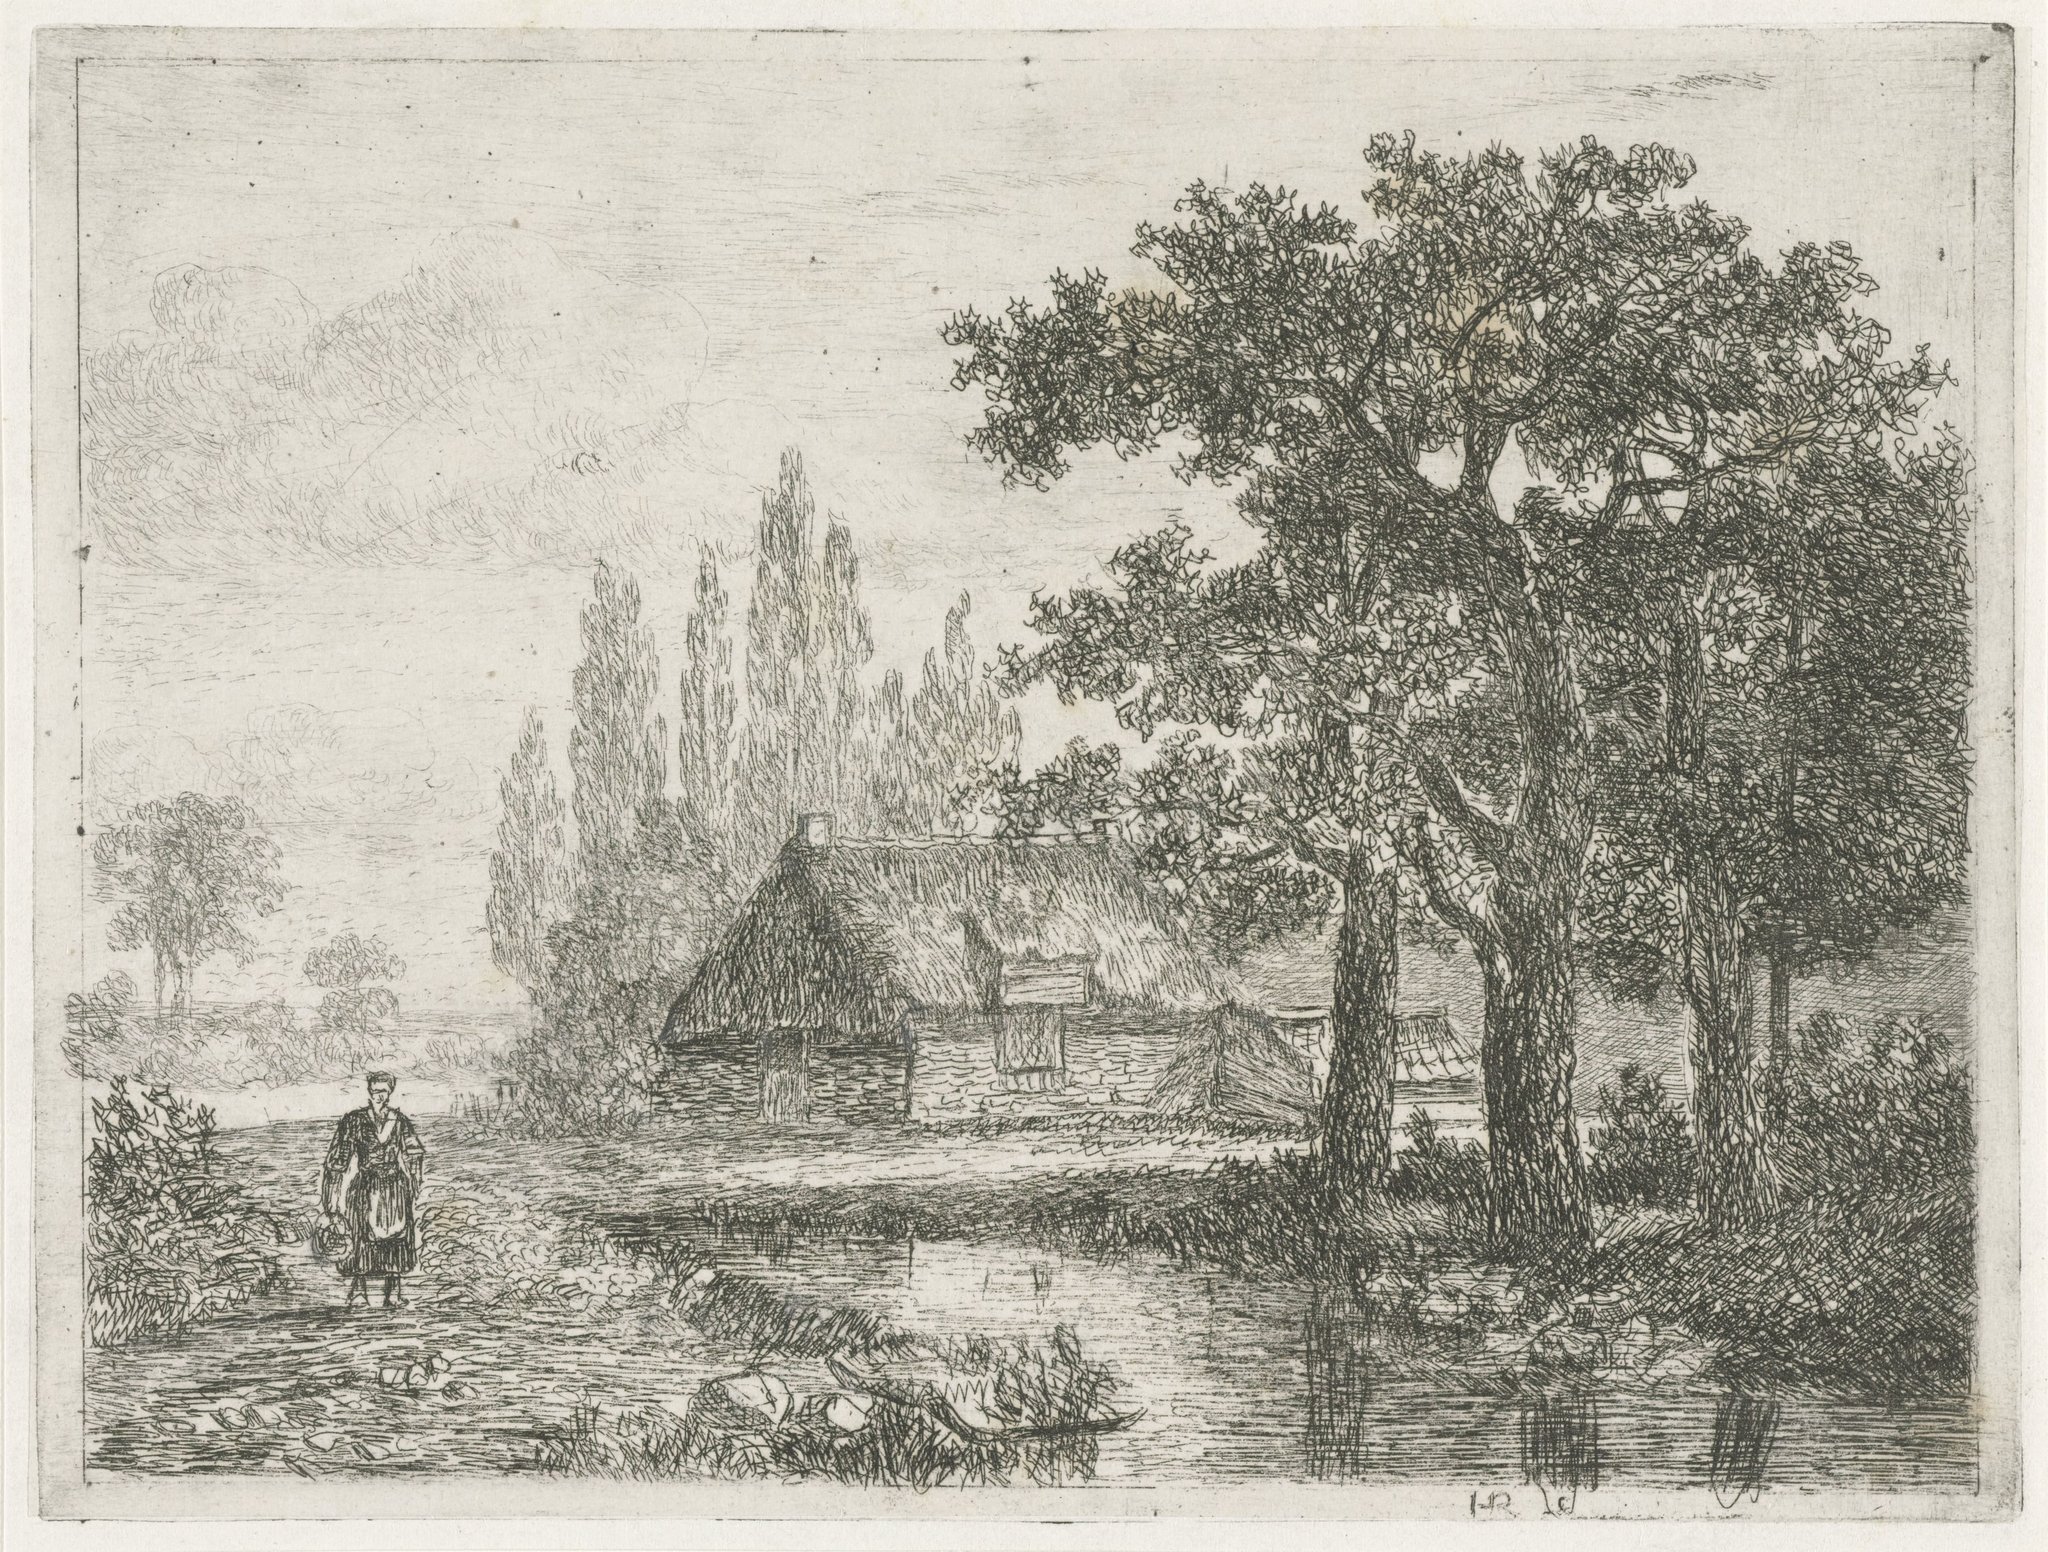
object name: print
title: Vrouw met een mand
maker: hermanus jan hendrik van rijkelijkhuysen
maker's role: painter, print maker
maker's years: 1813-1883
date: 1823-1883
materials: paper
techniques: drypoint, etching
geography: utrecht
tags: trees, river, farmers - aa - female farmer, farmer's wife, farm or solitary house in landscape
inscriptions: collector's mark: Lugt 2228, collector's mark: Lugt 1485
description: Gezicht op een landschap met bomen en een rivier met rechts een boerenhoeve. Op de voorgrond een vrouw met een mand.